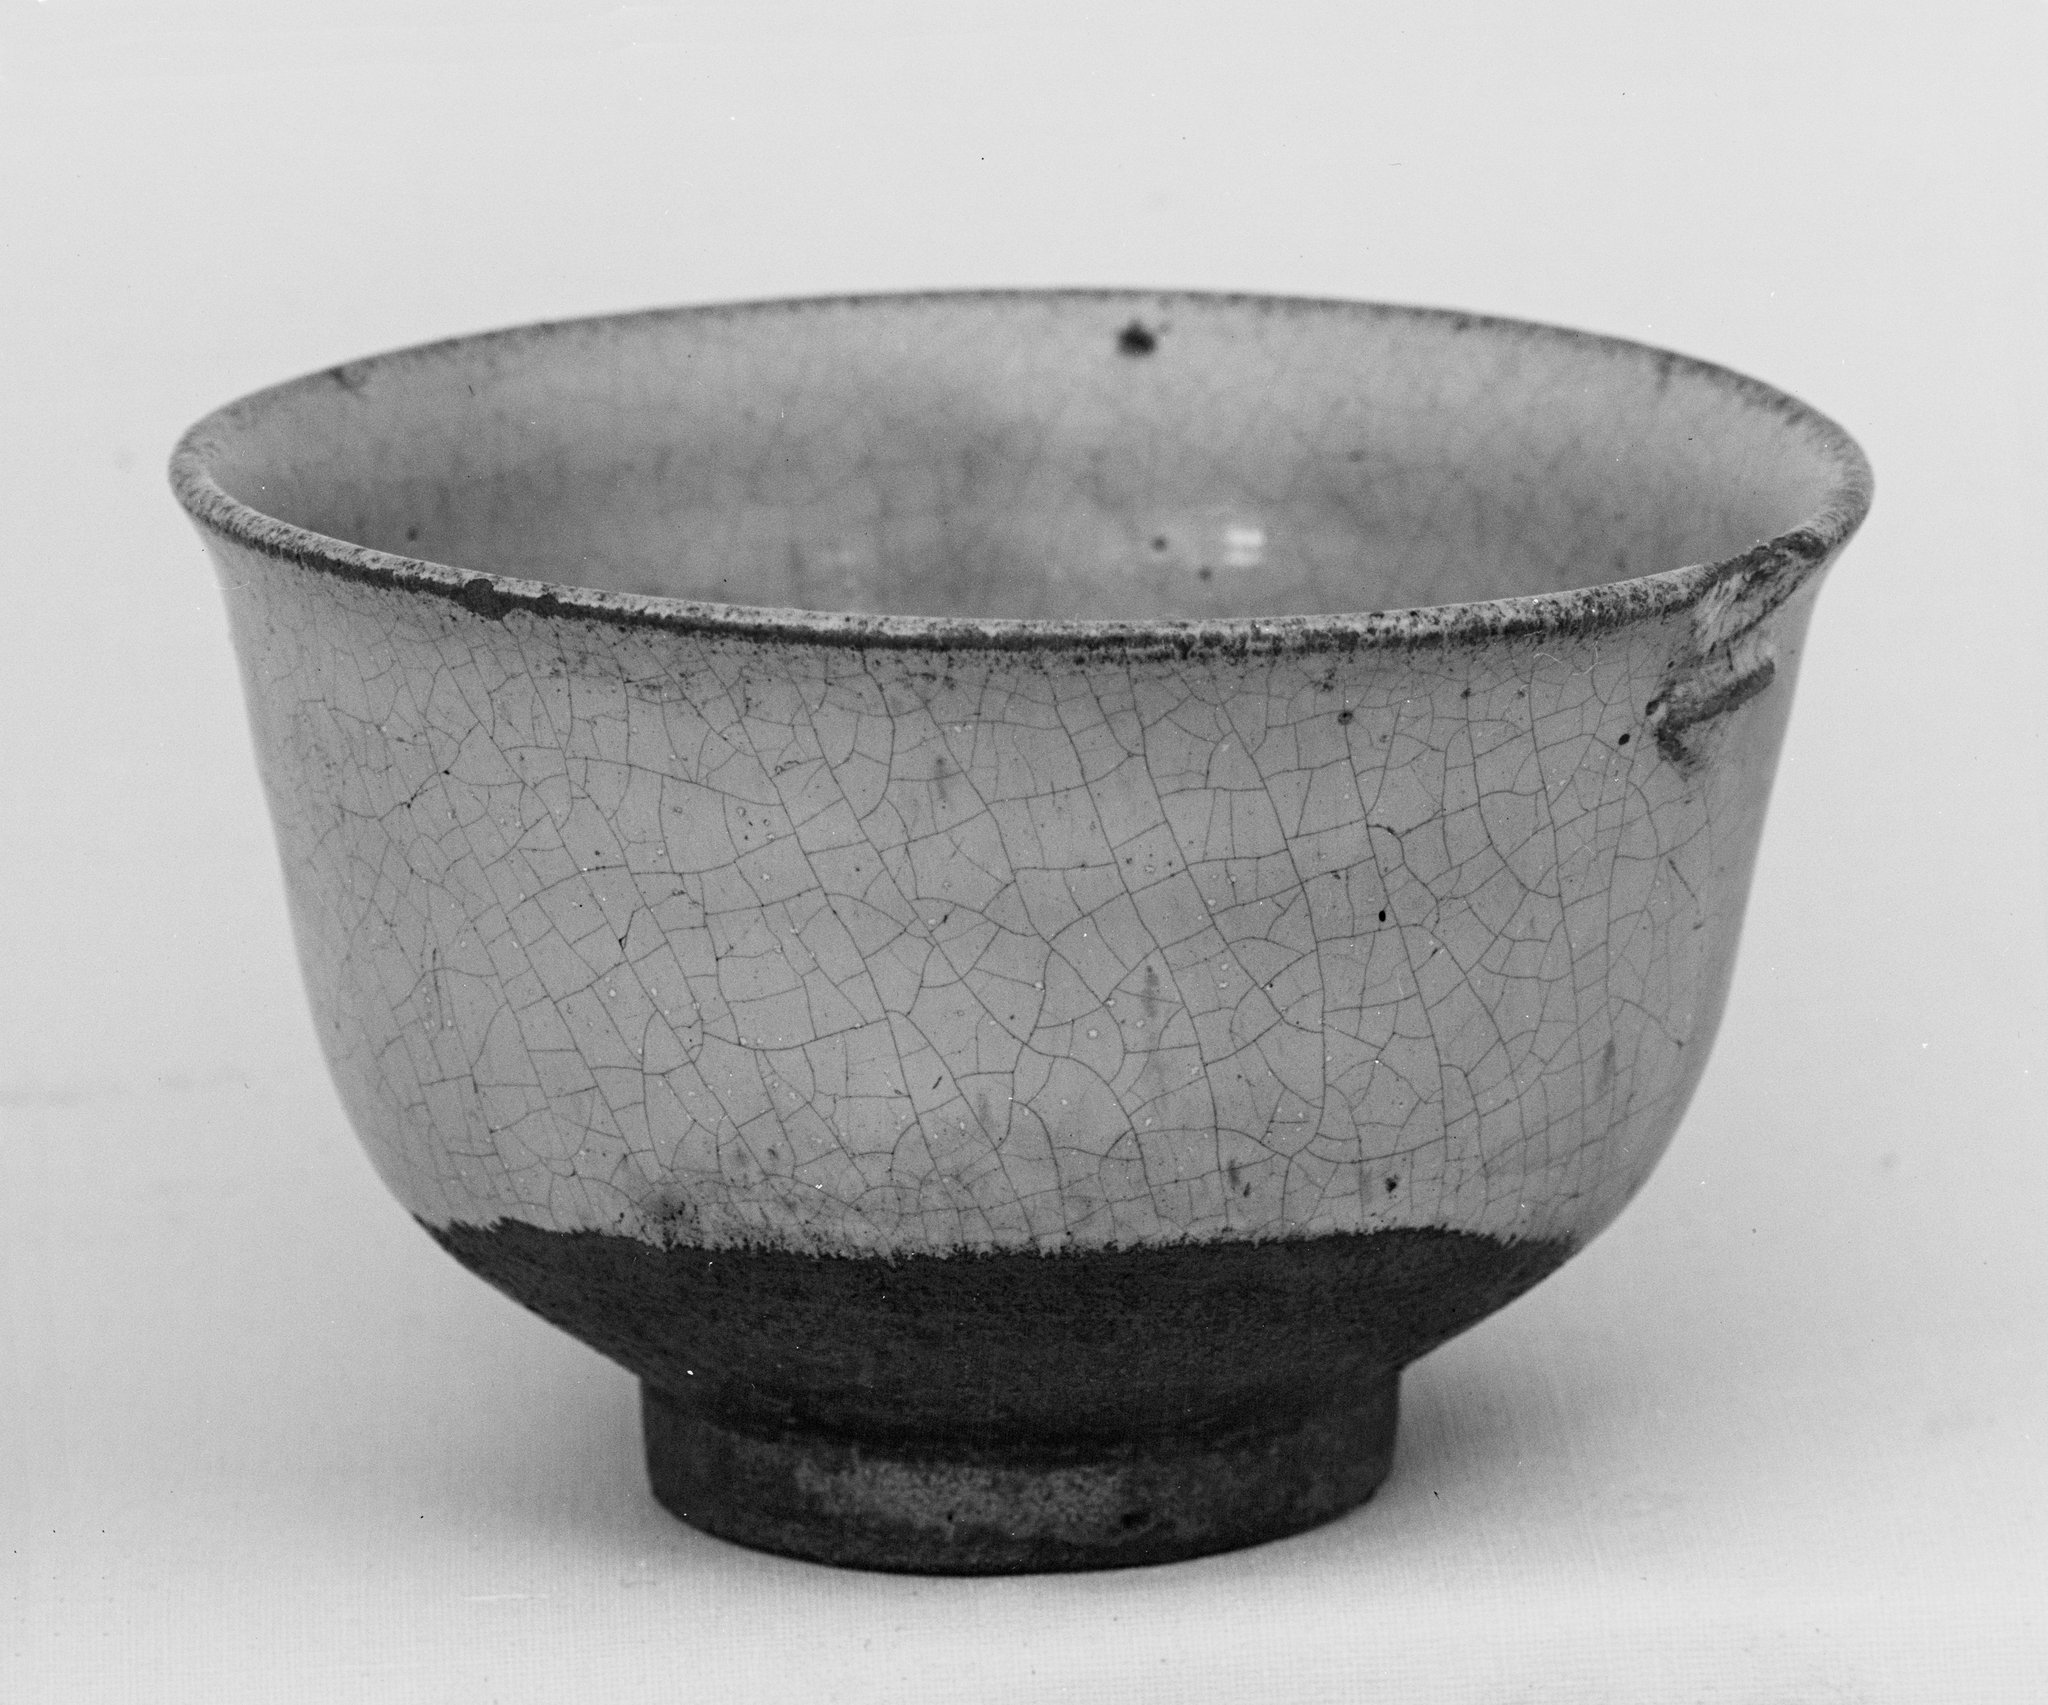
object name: bowl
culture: japanese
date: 1700-1780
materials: glaze, pottery